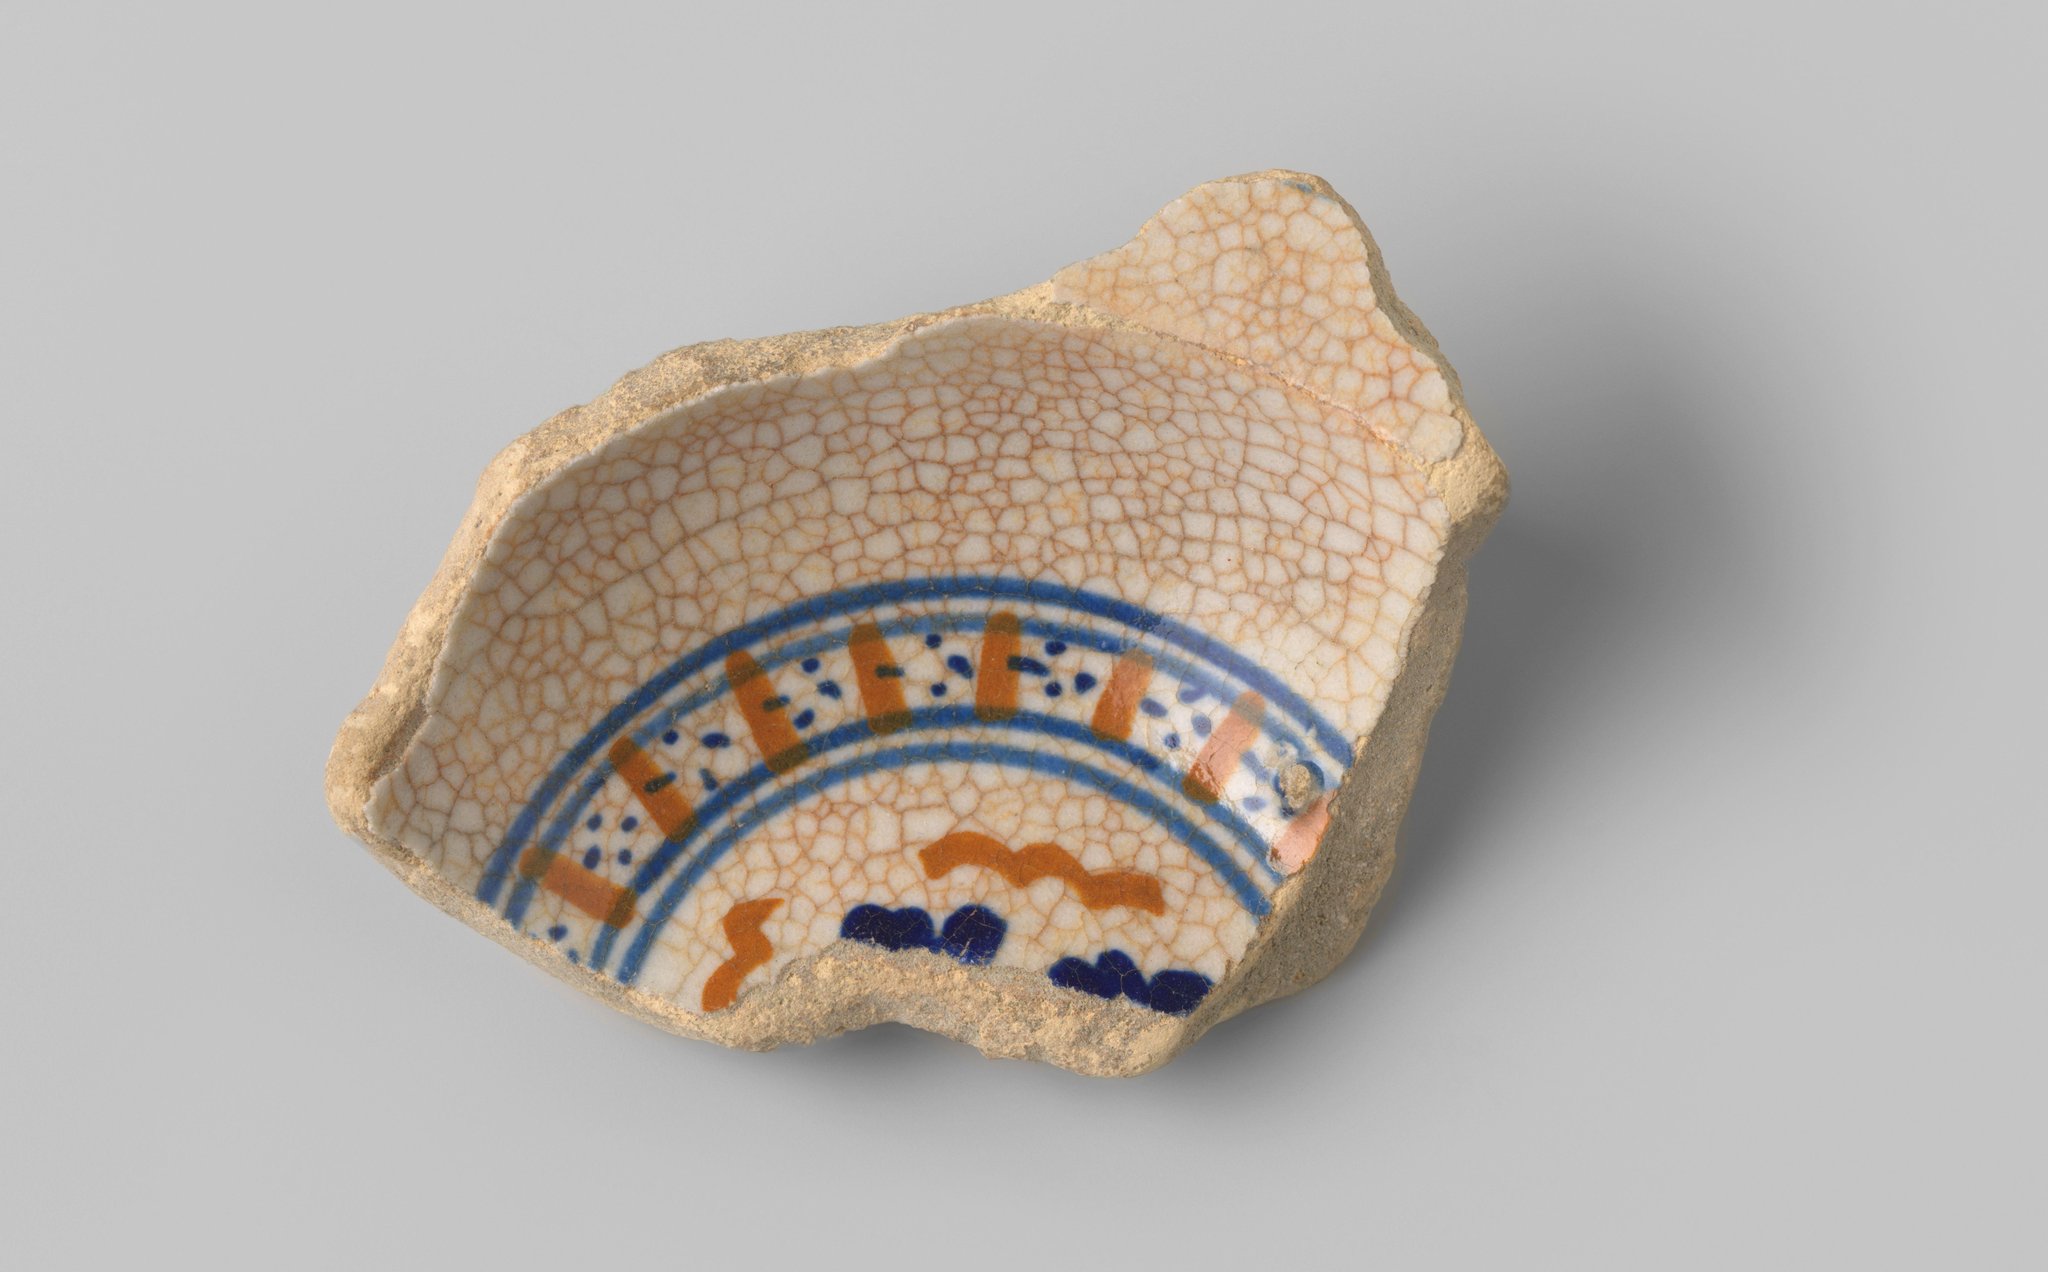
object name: sherd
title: Fragment van een schotel met witbakkende scherf, met aan de voor- en achterzijde wit glazuur, waarop aan de voorzijde in oranje, licht- en donkerblauw strepen en stippen zijn beschilderd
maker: Anonymous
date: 1200-1899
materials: earthenware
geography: italy